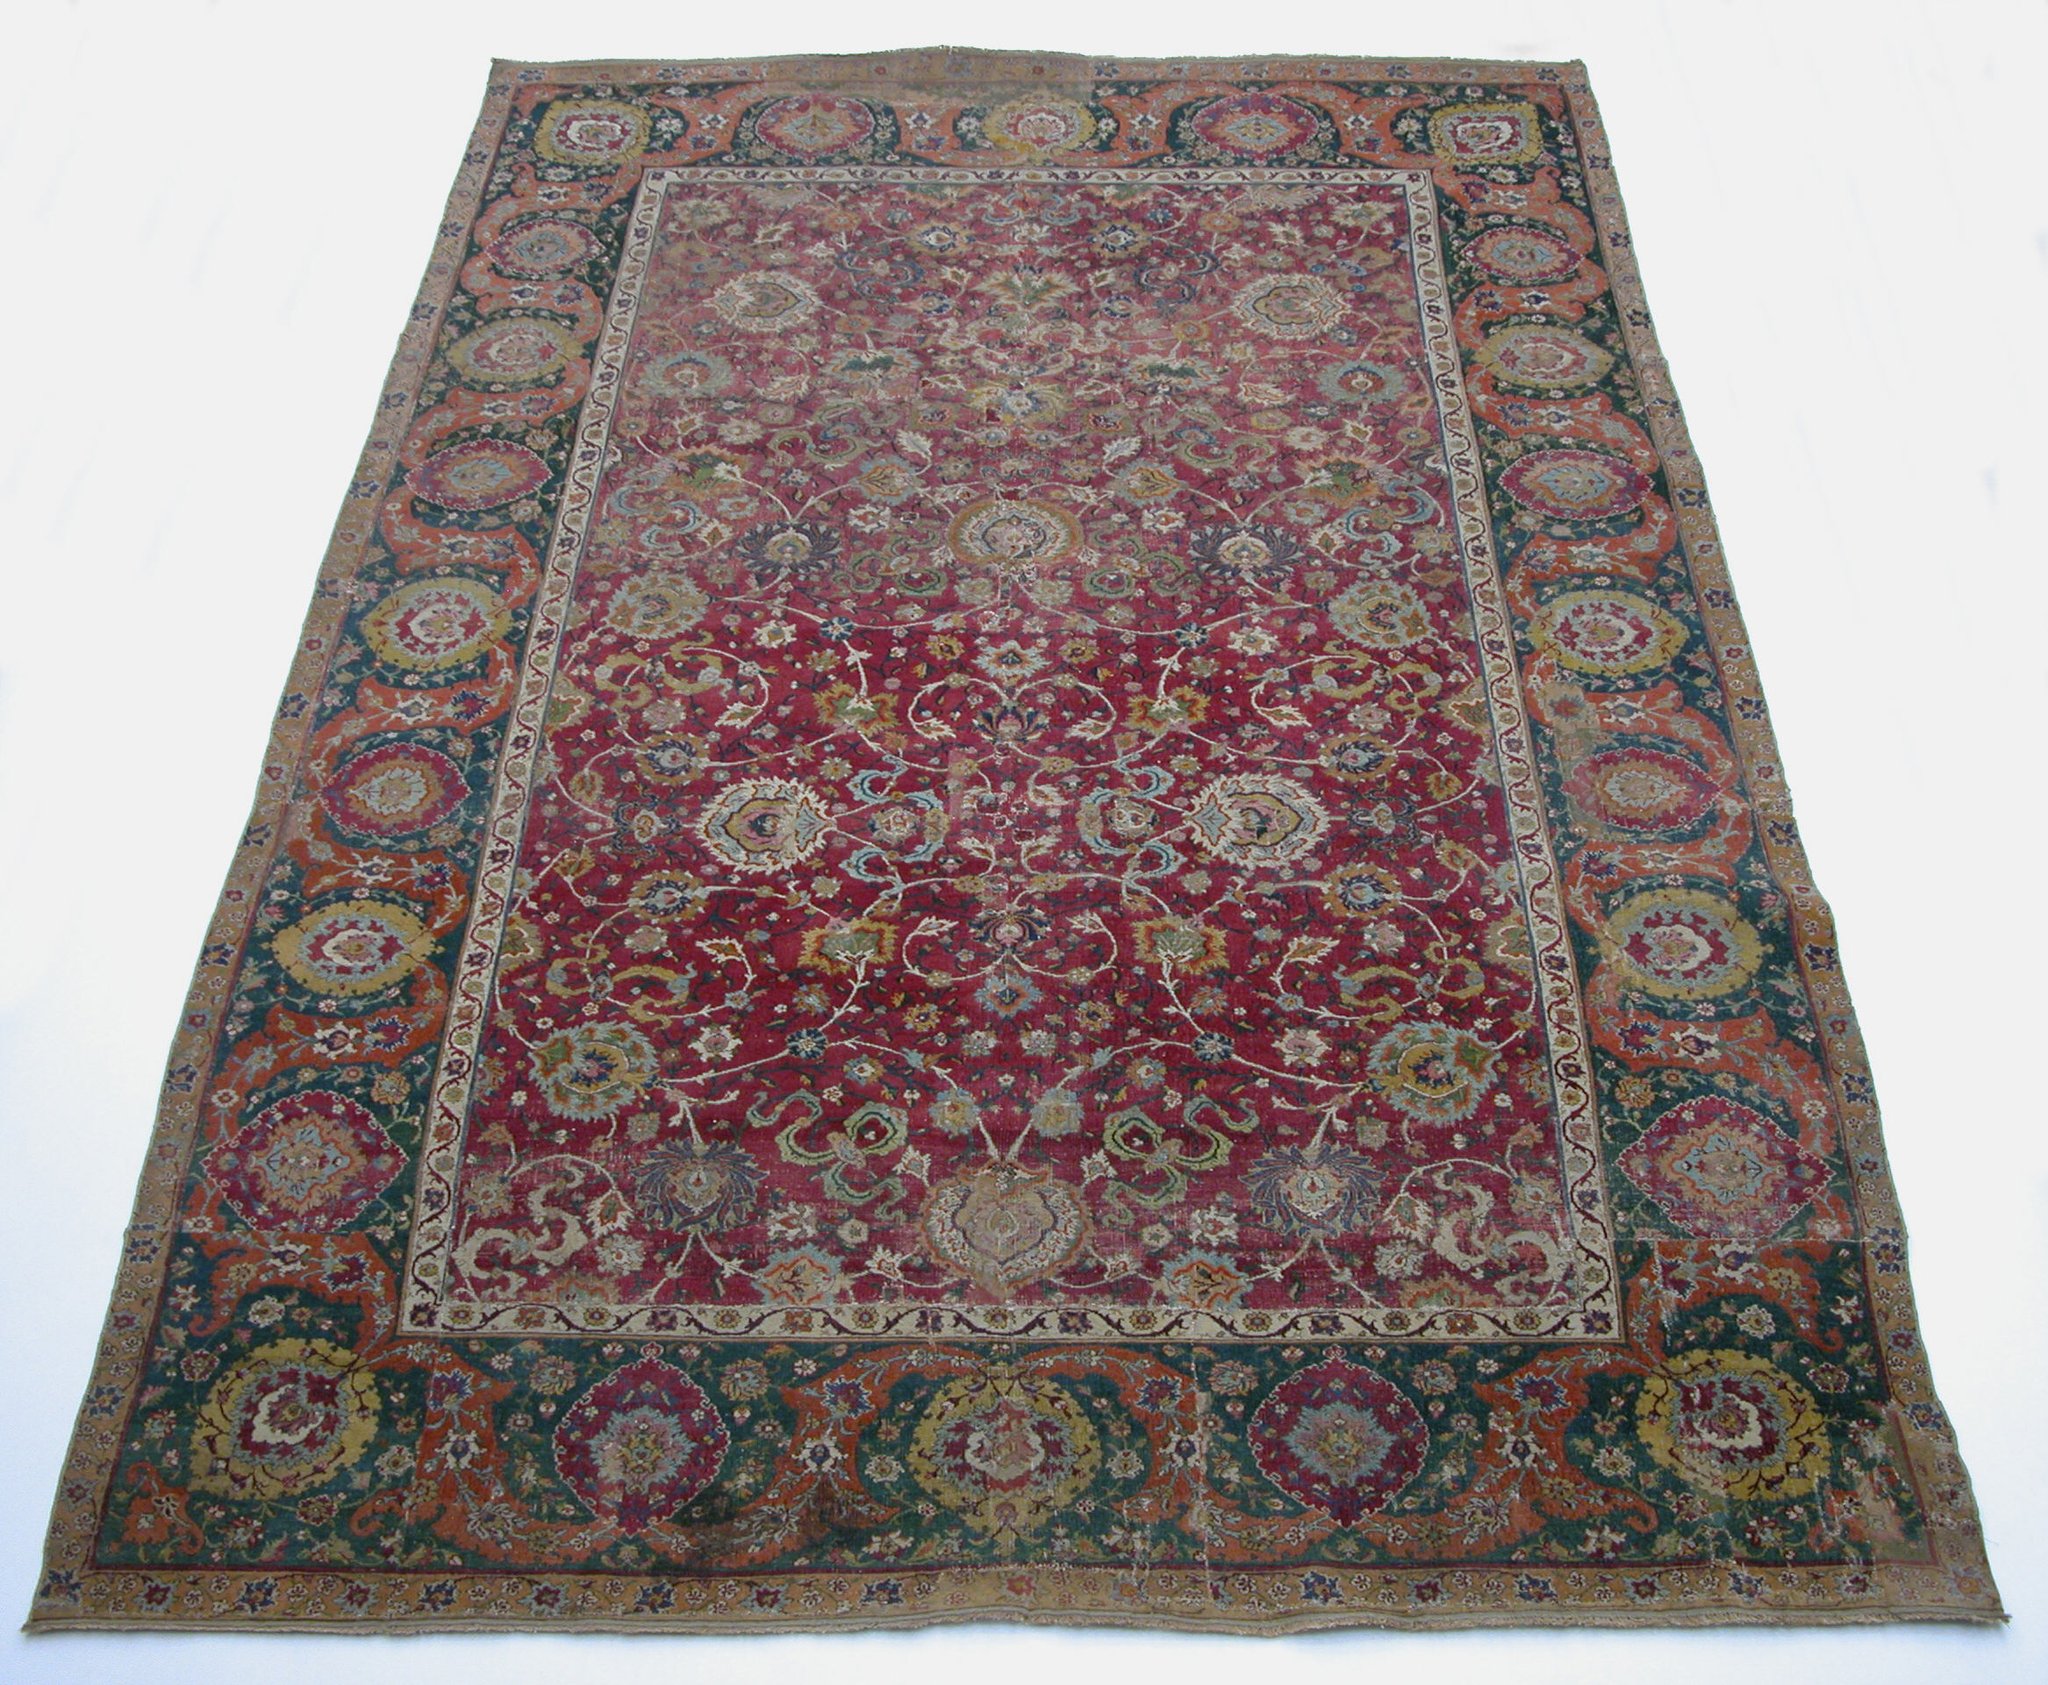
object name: carpet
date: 1534-1566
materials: cotton, wool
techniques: asymmetrically knotted pile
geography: iran